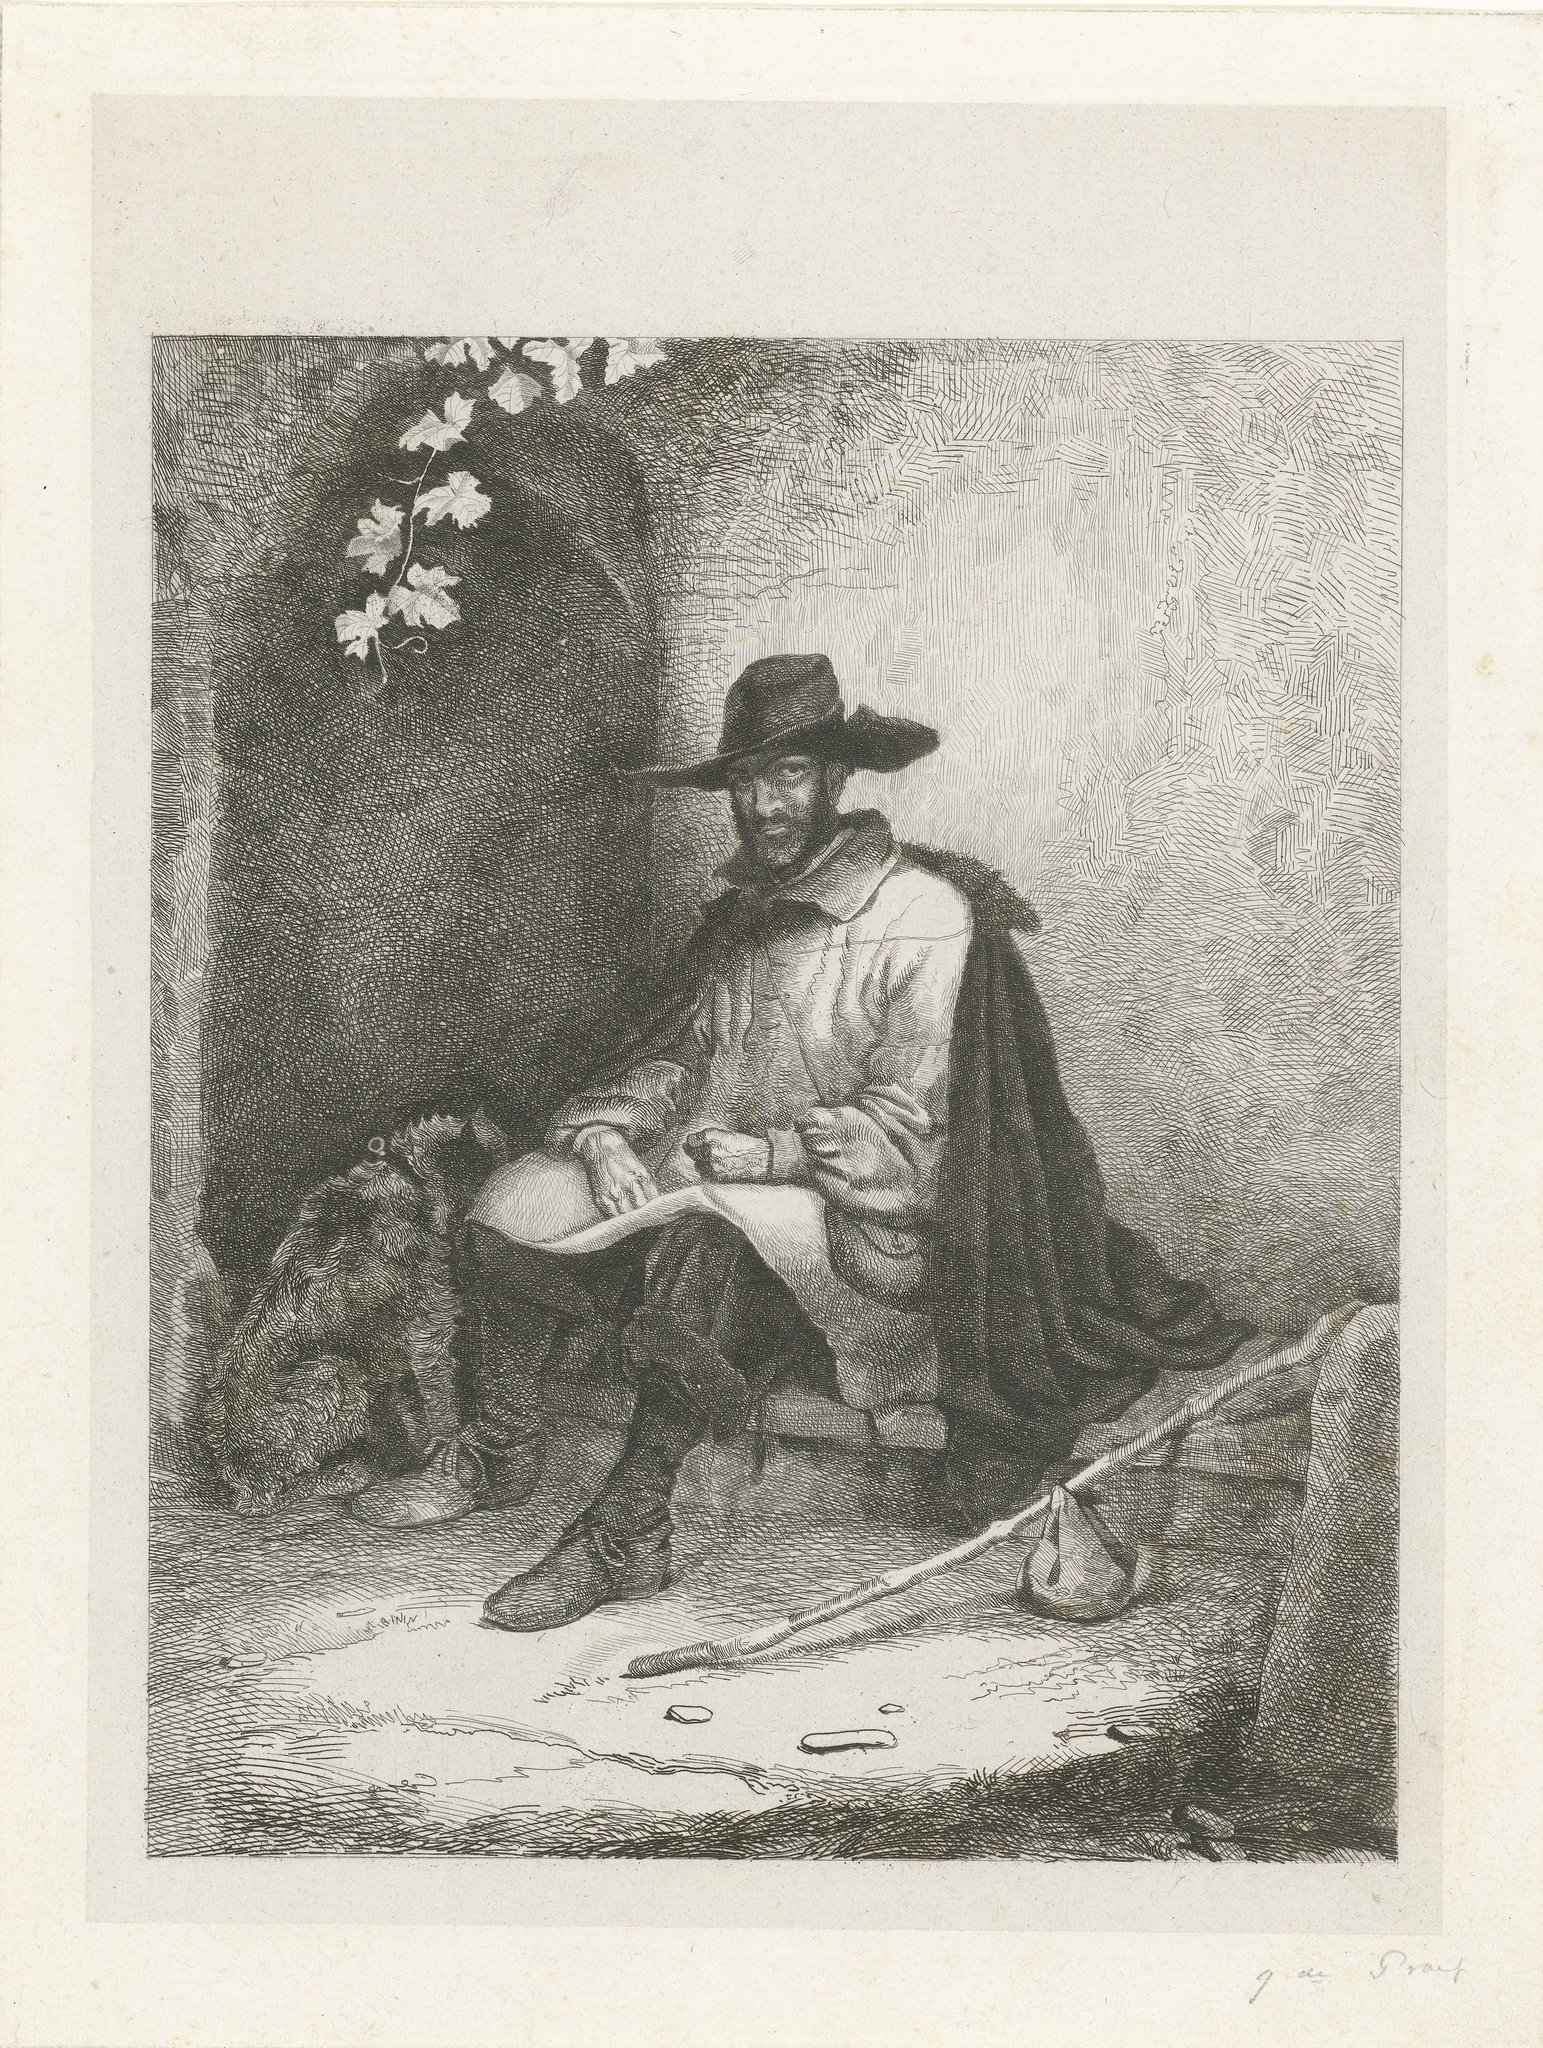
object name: print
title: Rustende reiziger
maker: jacobus ludovicus cornet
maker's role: draughtsman, print maker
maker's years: 1815-1882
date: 1851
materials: paper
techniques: etching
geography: leiden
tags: (traveller) resting in the open air, dog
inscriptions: collector's mark: Lugt 2228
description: Een reiziger rust uit voor de ingang van een grot. Naast hem een hond. De man draagt een mantel en een hoge hoed.